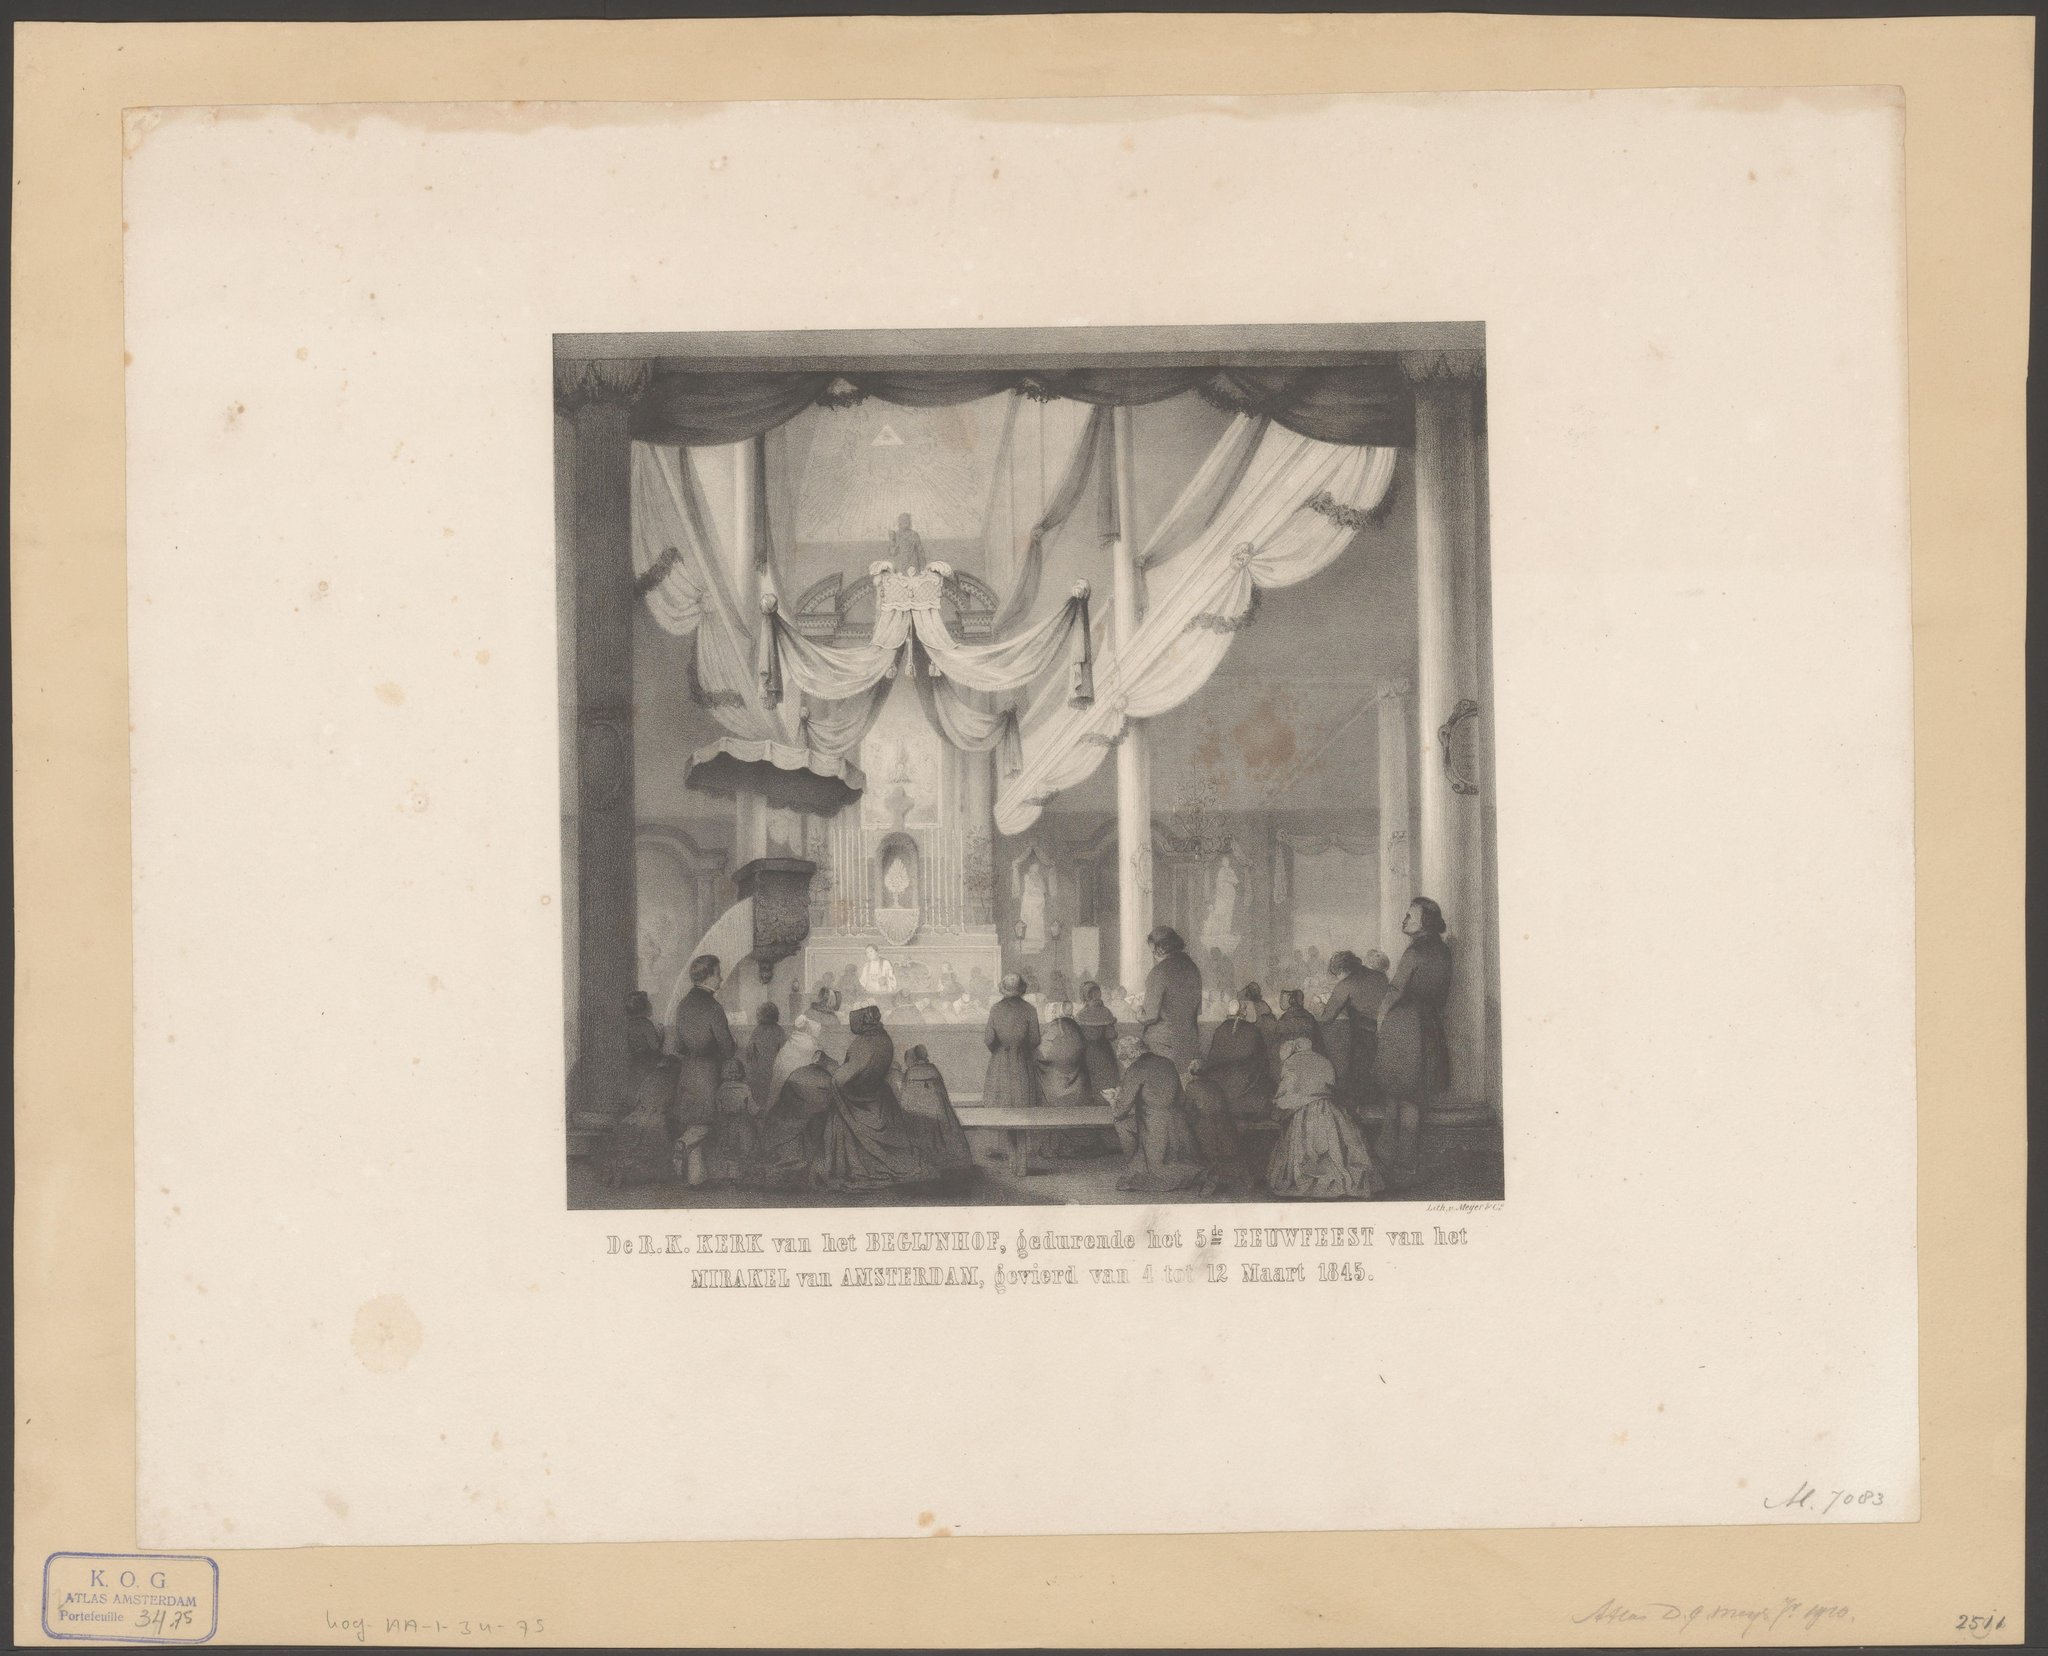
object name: print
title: Viering van het vijfde eeuwfeest van het Mirakel van Amsterdam in de Begijnhofkapel te Amsterdam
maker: Anonymous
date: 1845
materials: paper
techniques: lithograph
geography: netherlands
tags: interior of church, holy mass (divine service, especially of roman catholic church)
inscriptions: collector's mark: Lugt 1641b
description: Onderwerpsrubriek binnen de Atlas Amsterdam: Kerkwezen: R.K. Gemeenten: Begijnhof t/m Petrus en Paulus.